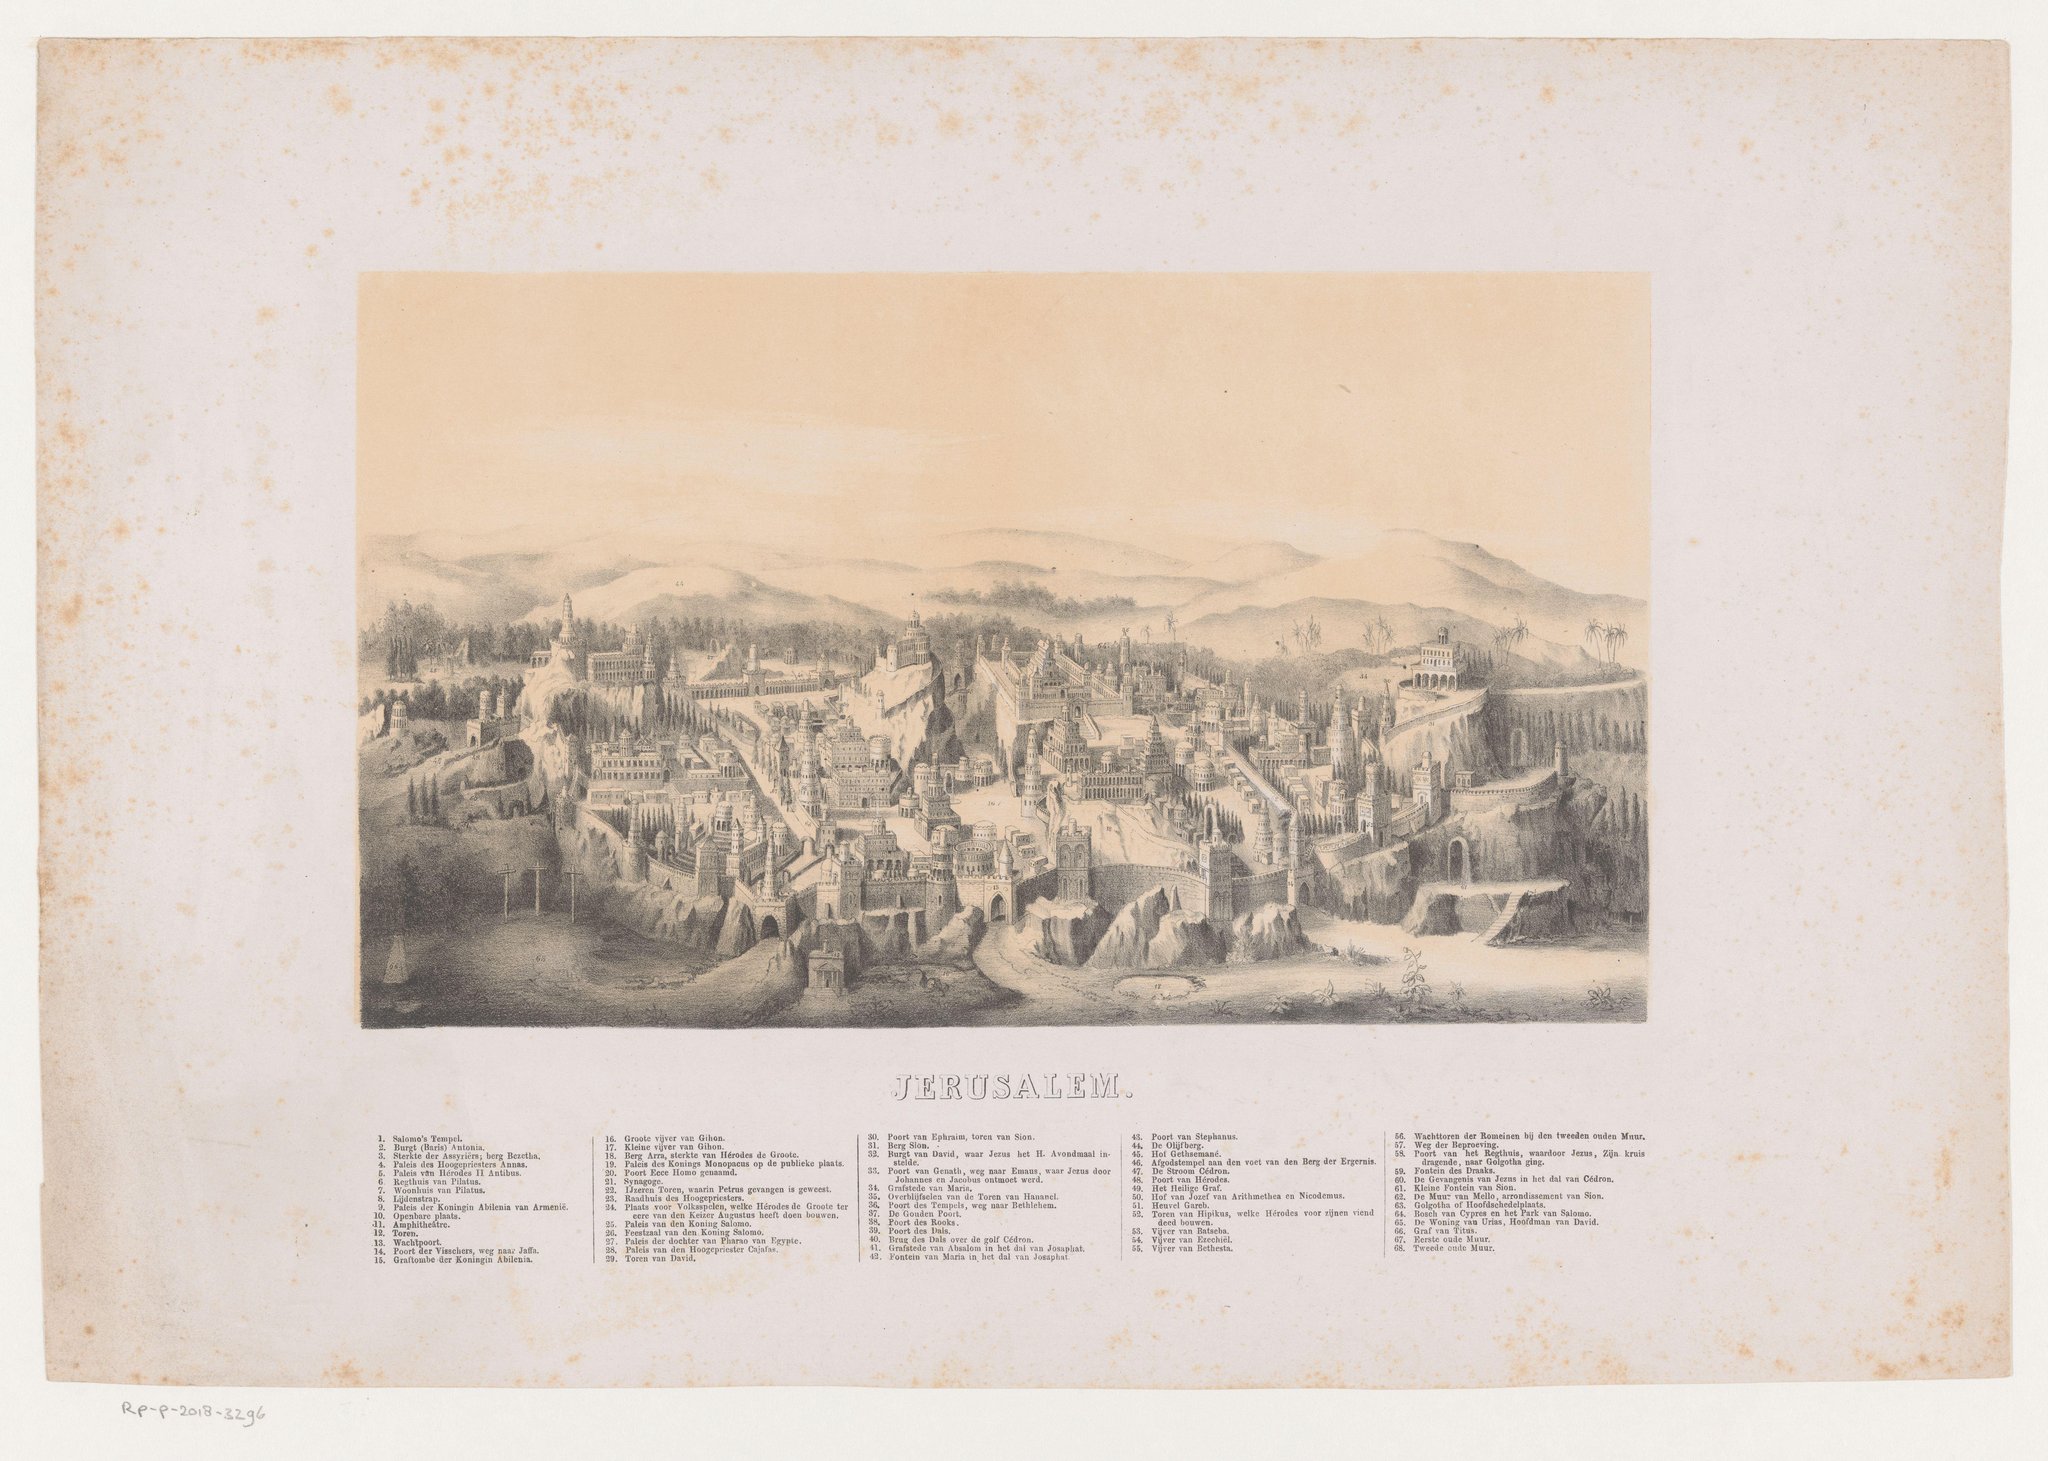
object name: print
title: Gezicht op Jeruzalem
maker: Anonymous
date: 1800-1850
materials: paper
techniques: tone lithography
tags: prospect of city, town panorama, silhouette of city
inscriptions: collector's mark: Lugt 2228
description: Gezicht op de stad Jeruzalem met daaronder een lijst met nummers en gebouw aanduidingen.